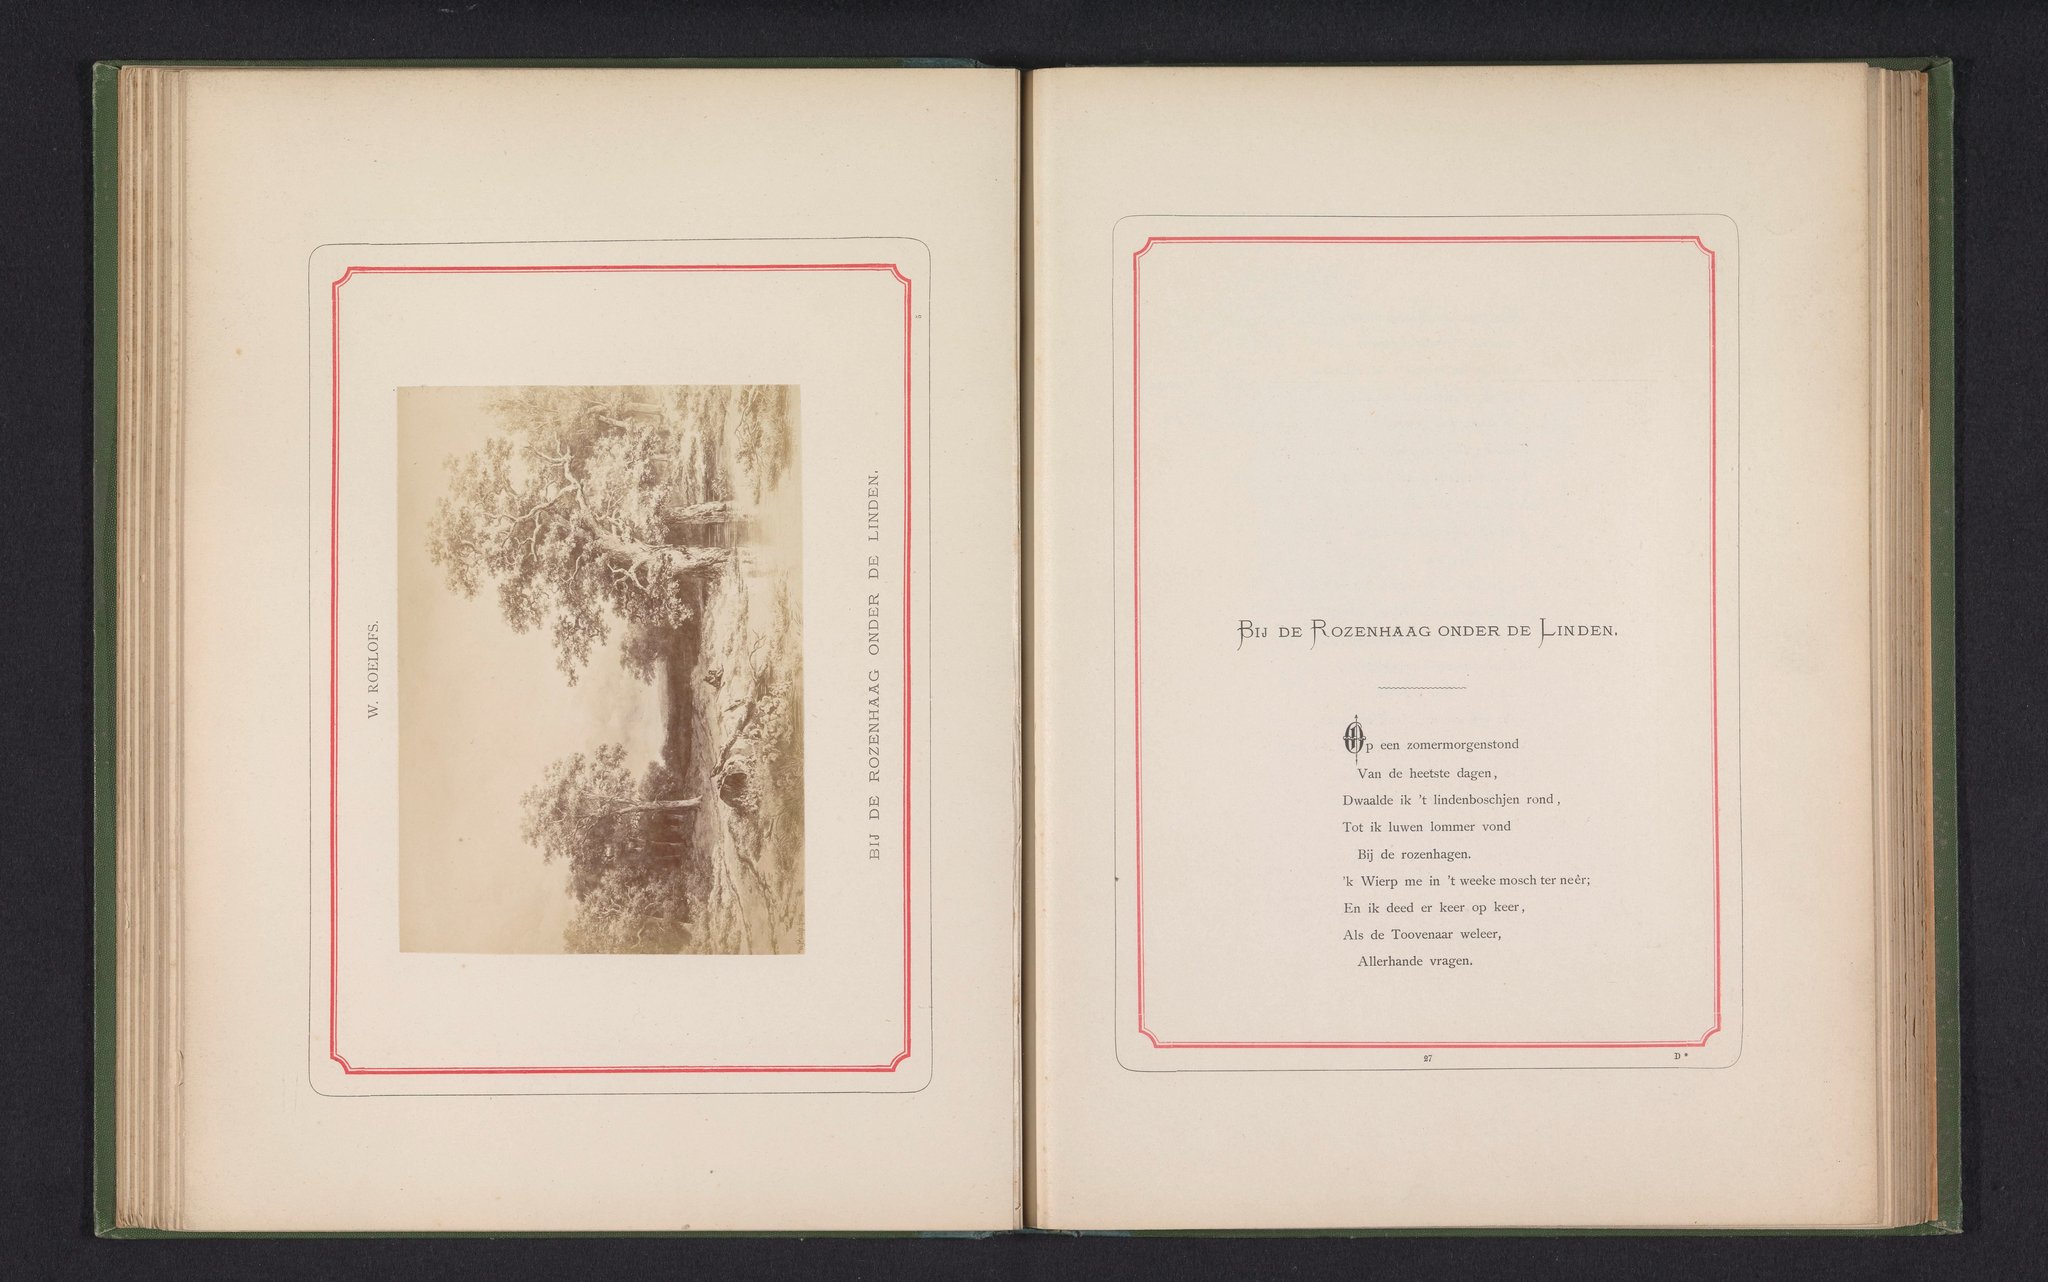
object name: photograph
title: Fotoreproductie van een schilderij, voorstellende een zittende man in een boslandschap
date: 1868-1878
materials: photographic support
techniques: albumen print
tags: sitting figure, forest, wood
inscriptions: number: ‘5’